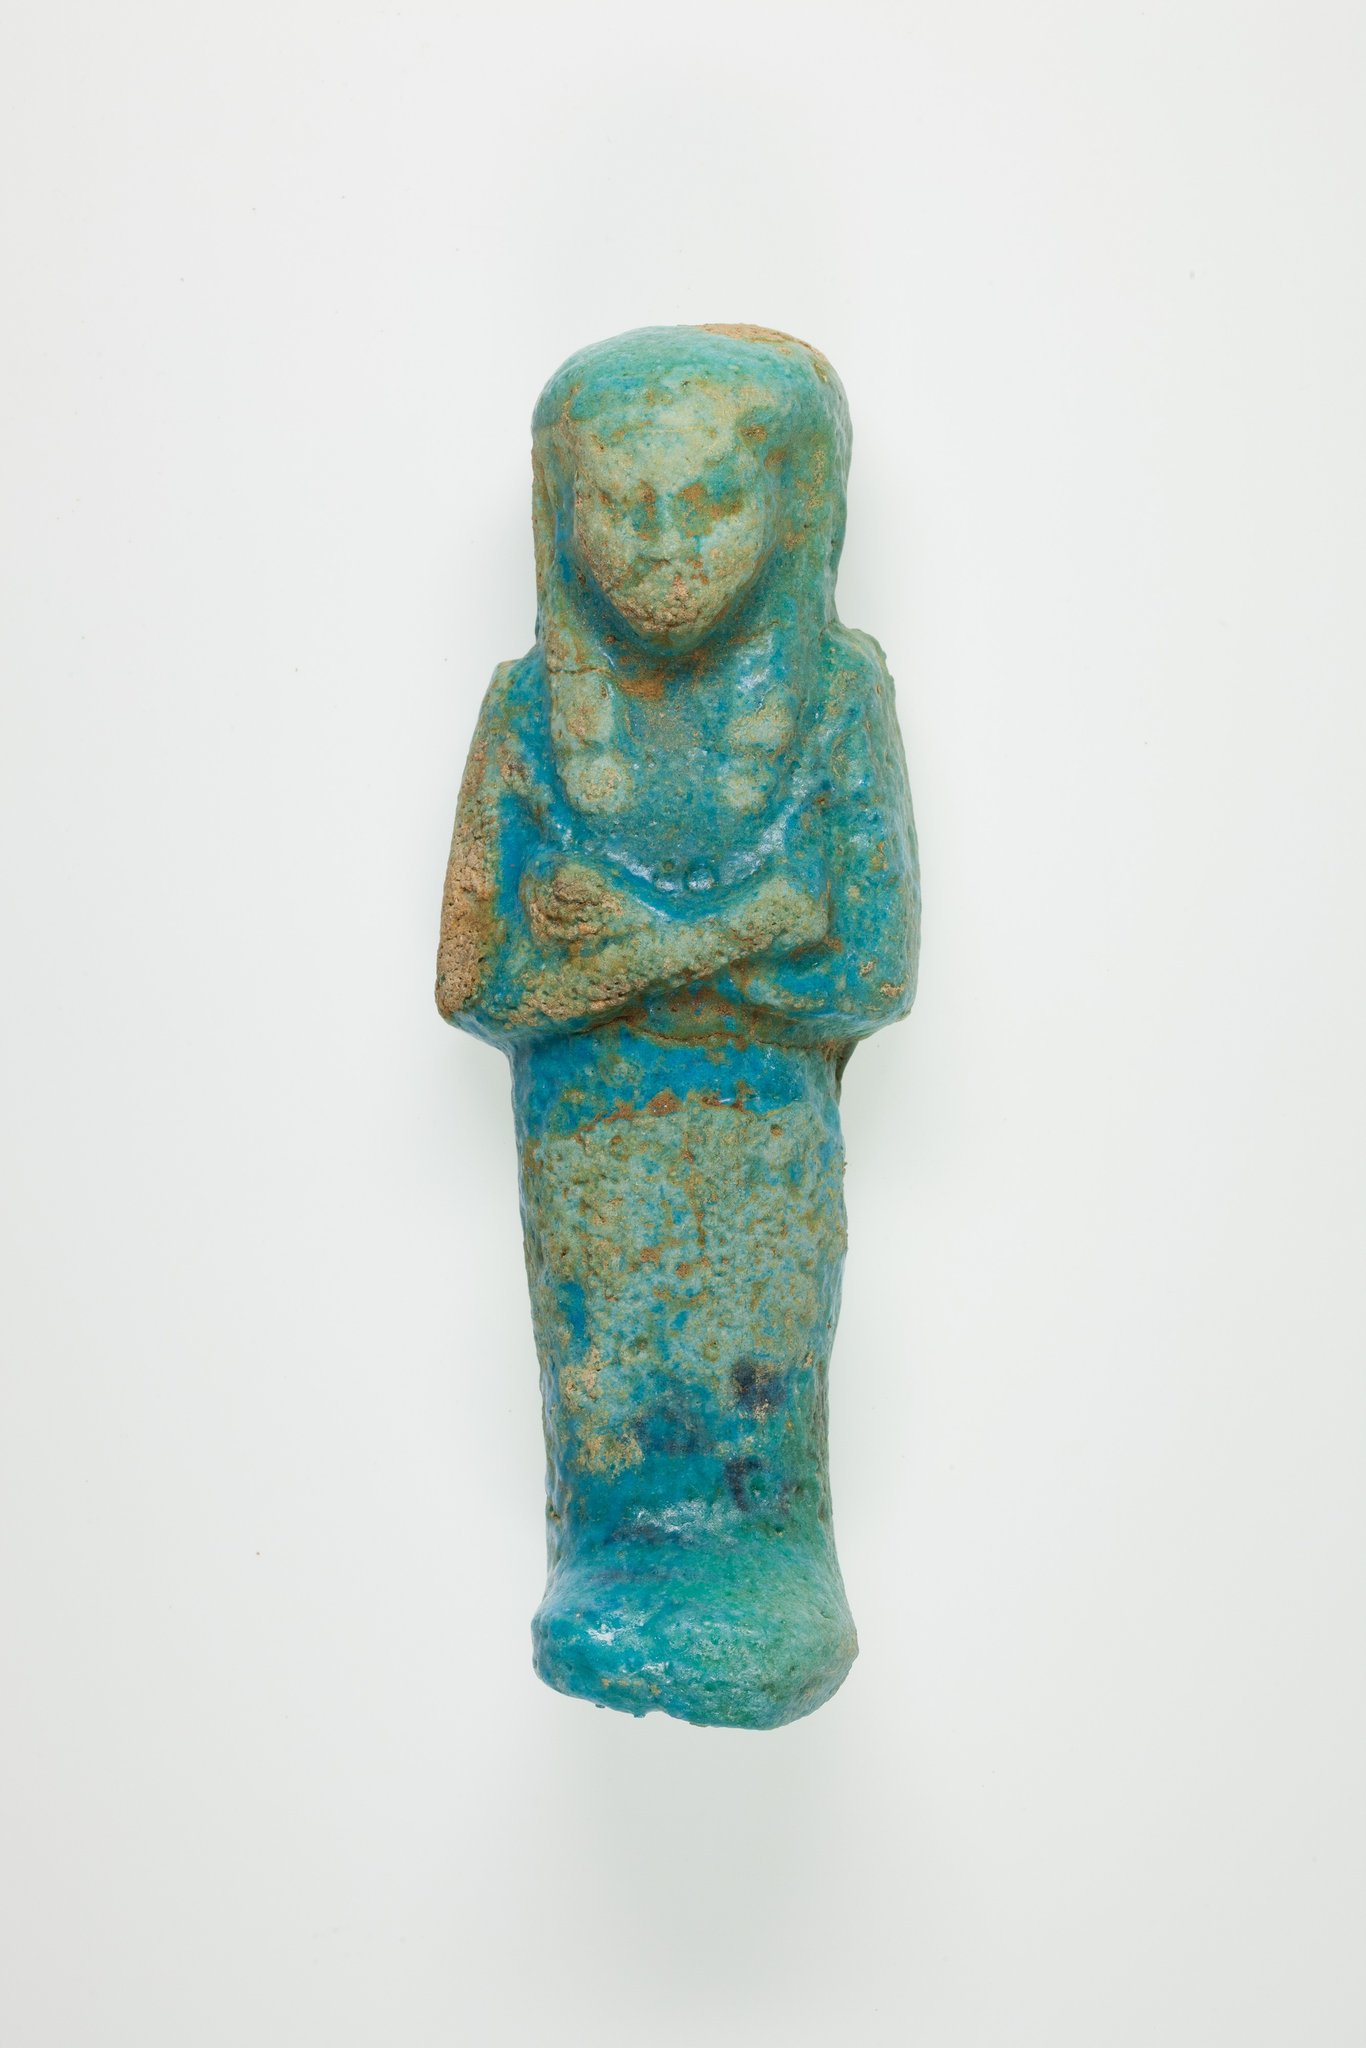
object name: shabti, henettawy c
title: Worker Shabti of Henettawy (C), Daughter of Isetemkheb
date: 990-970 BCE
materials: faience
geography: egypt